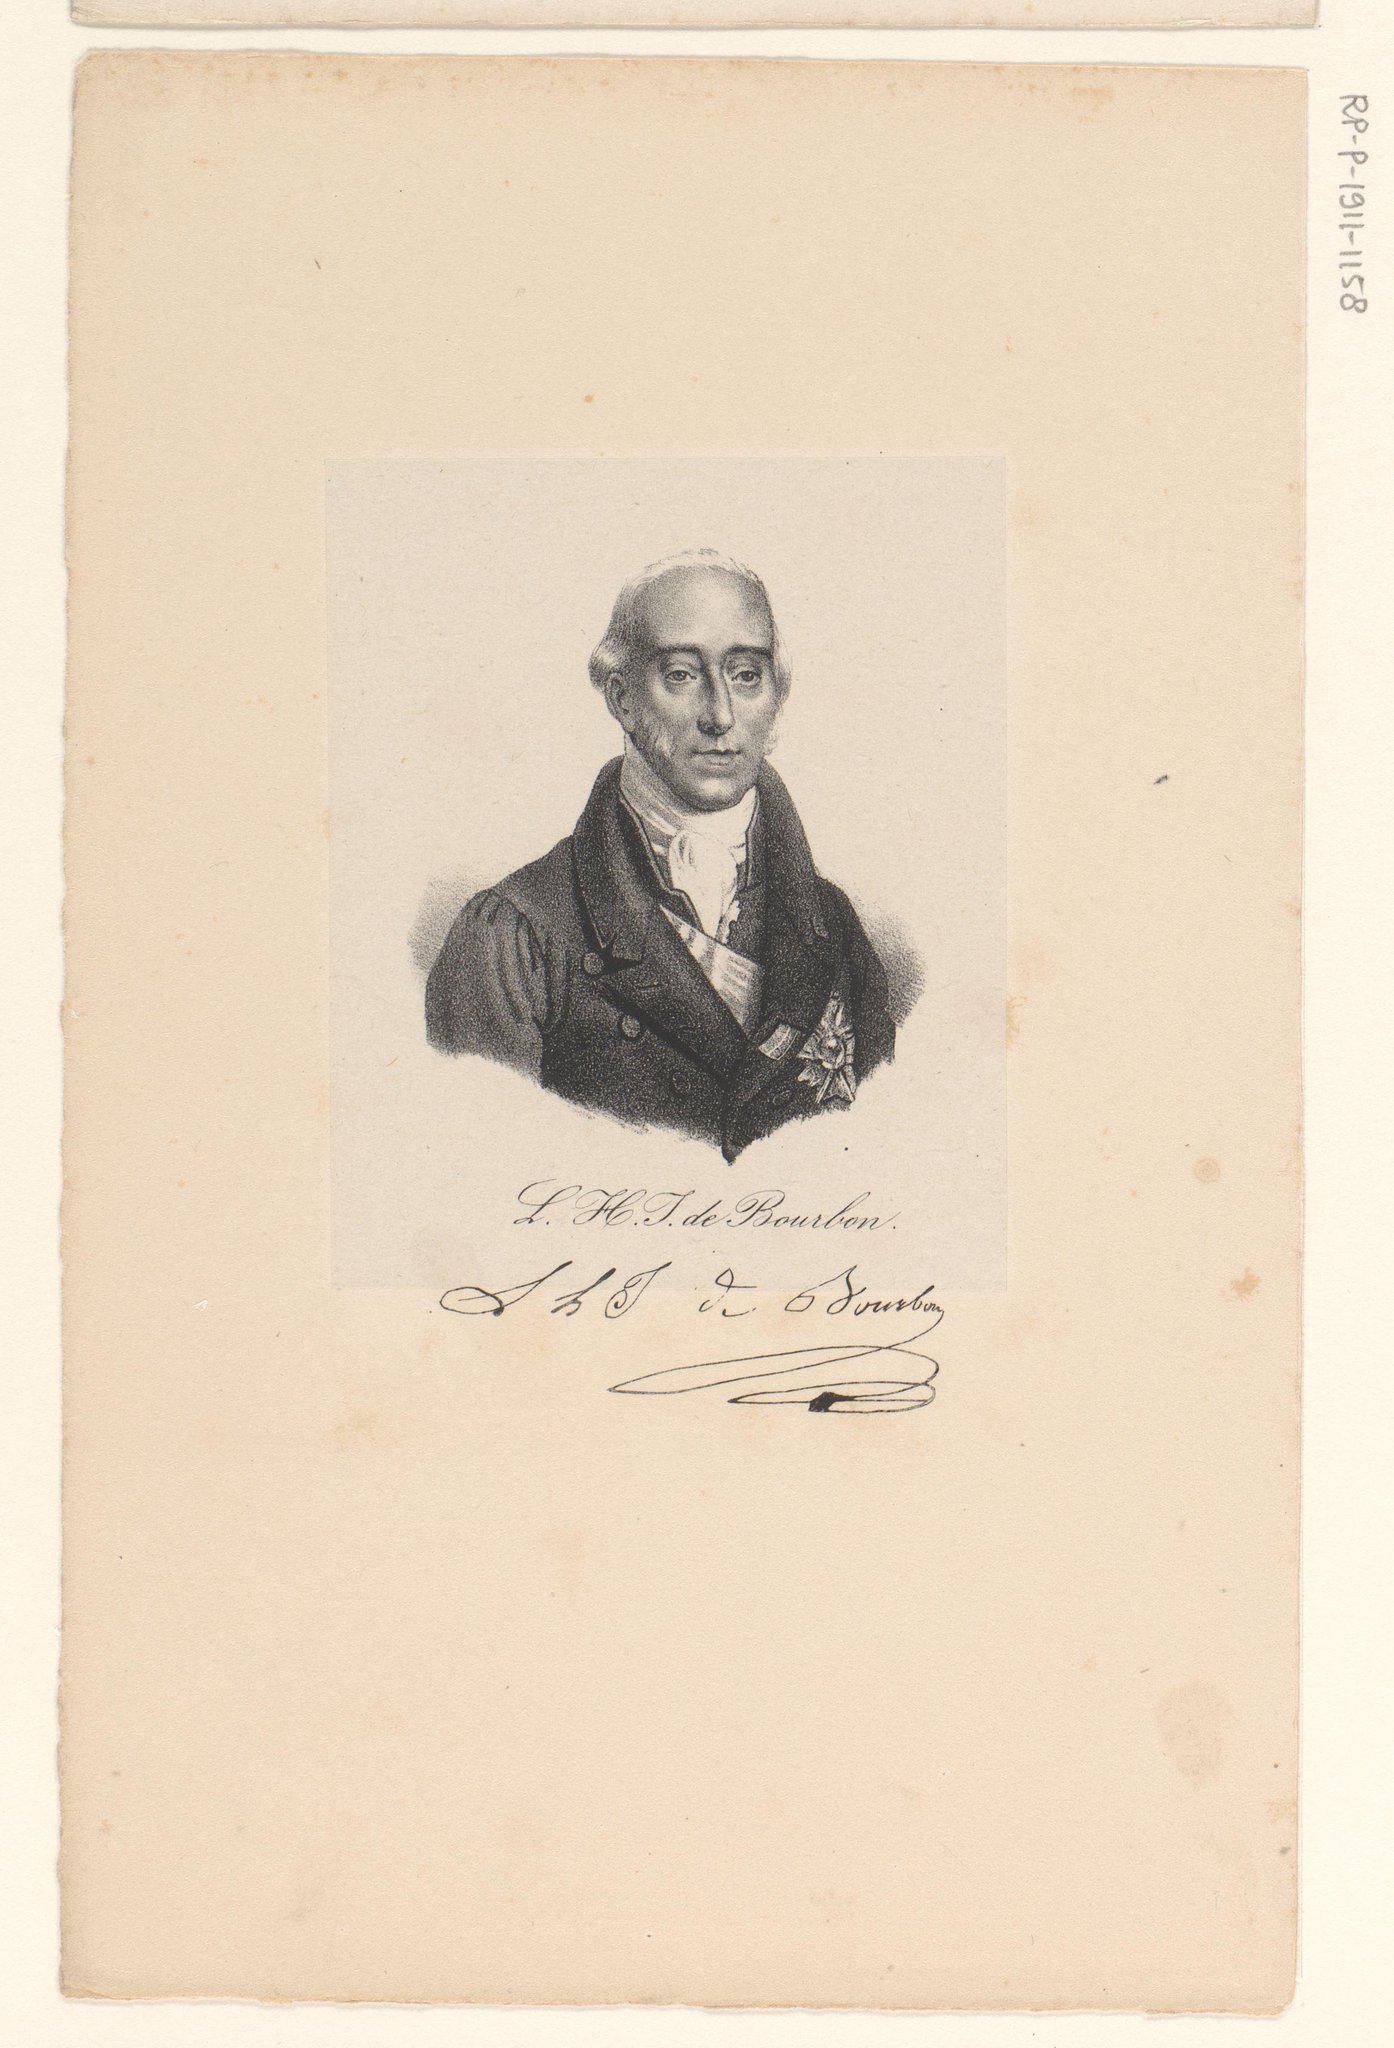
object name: print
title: L.H.J. de Bourbon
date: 1818-1842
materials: paper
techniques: lithograph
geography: paris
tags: paris, historical persons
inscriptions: collector's mark: Lugt 2228a